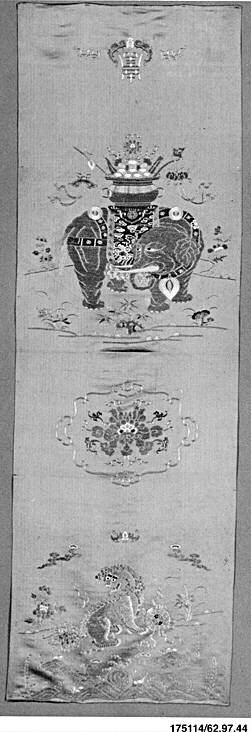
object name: chair strip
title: Chair Strip with Elephant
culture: chinese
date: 1701-1800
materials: feather, linen, metal thread, silk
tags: elephants,lions